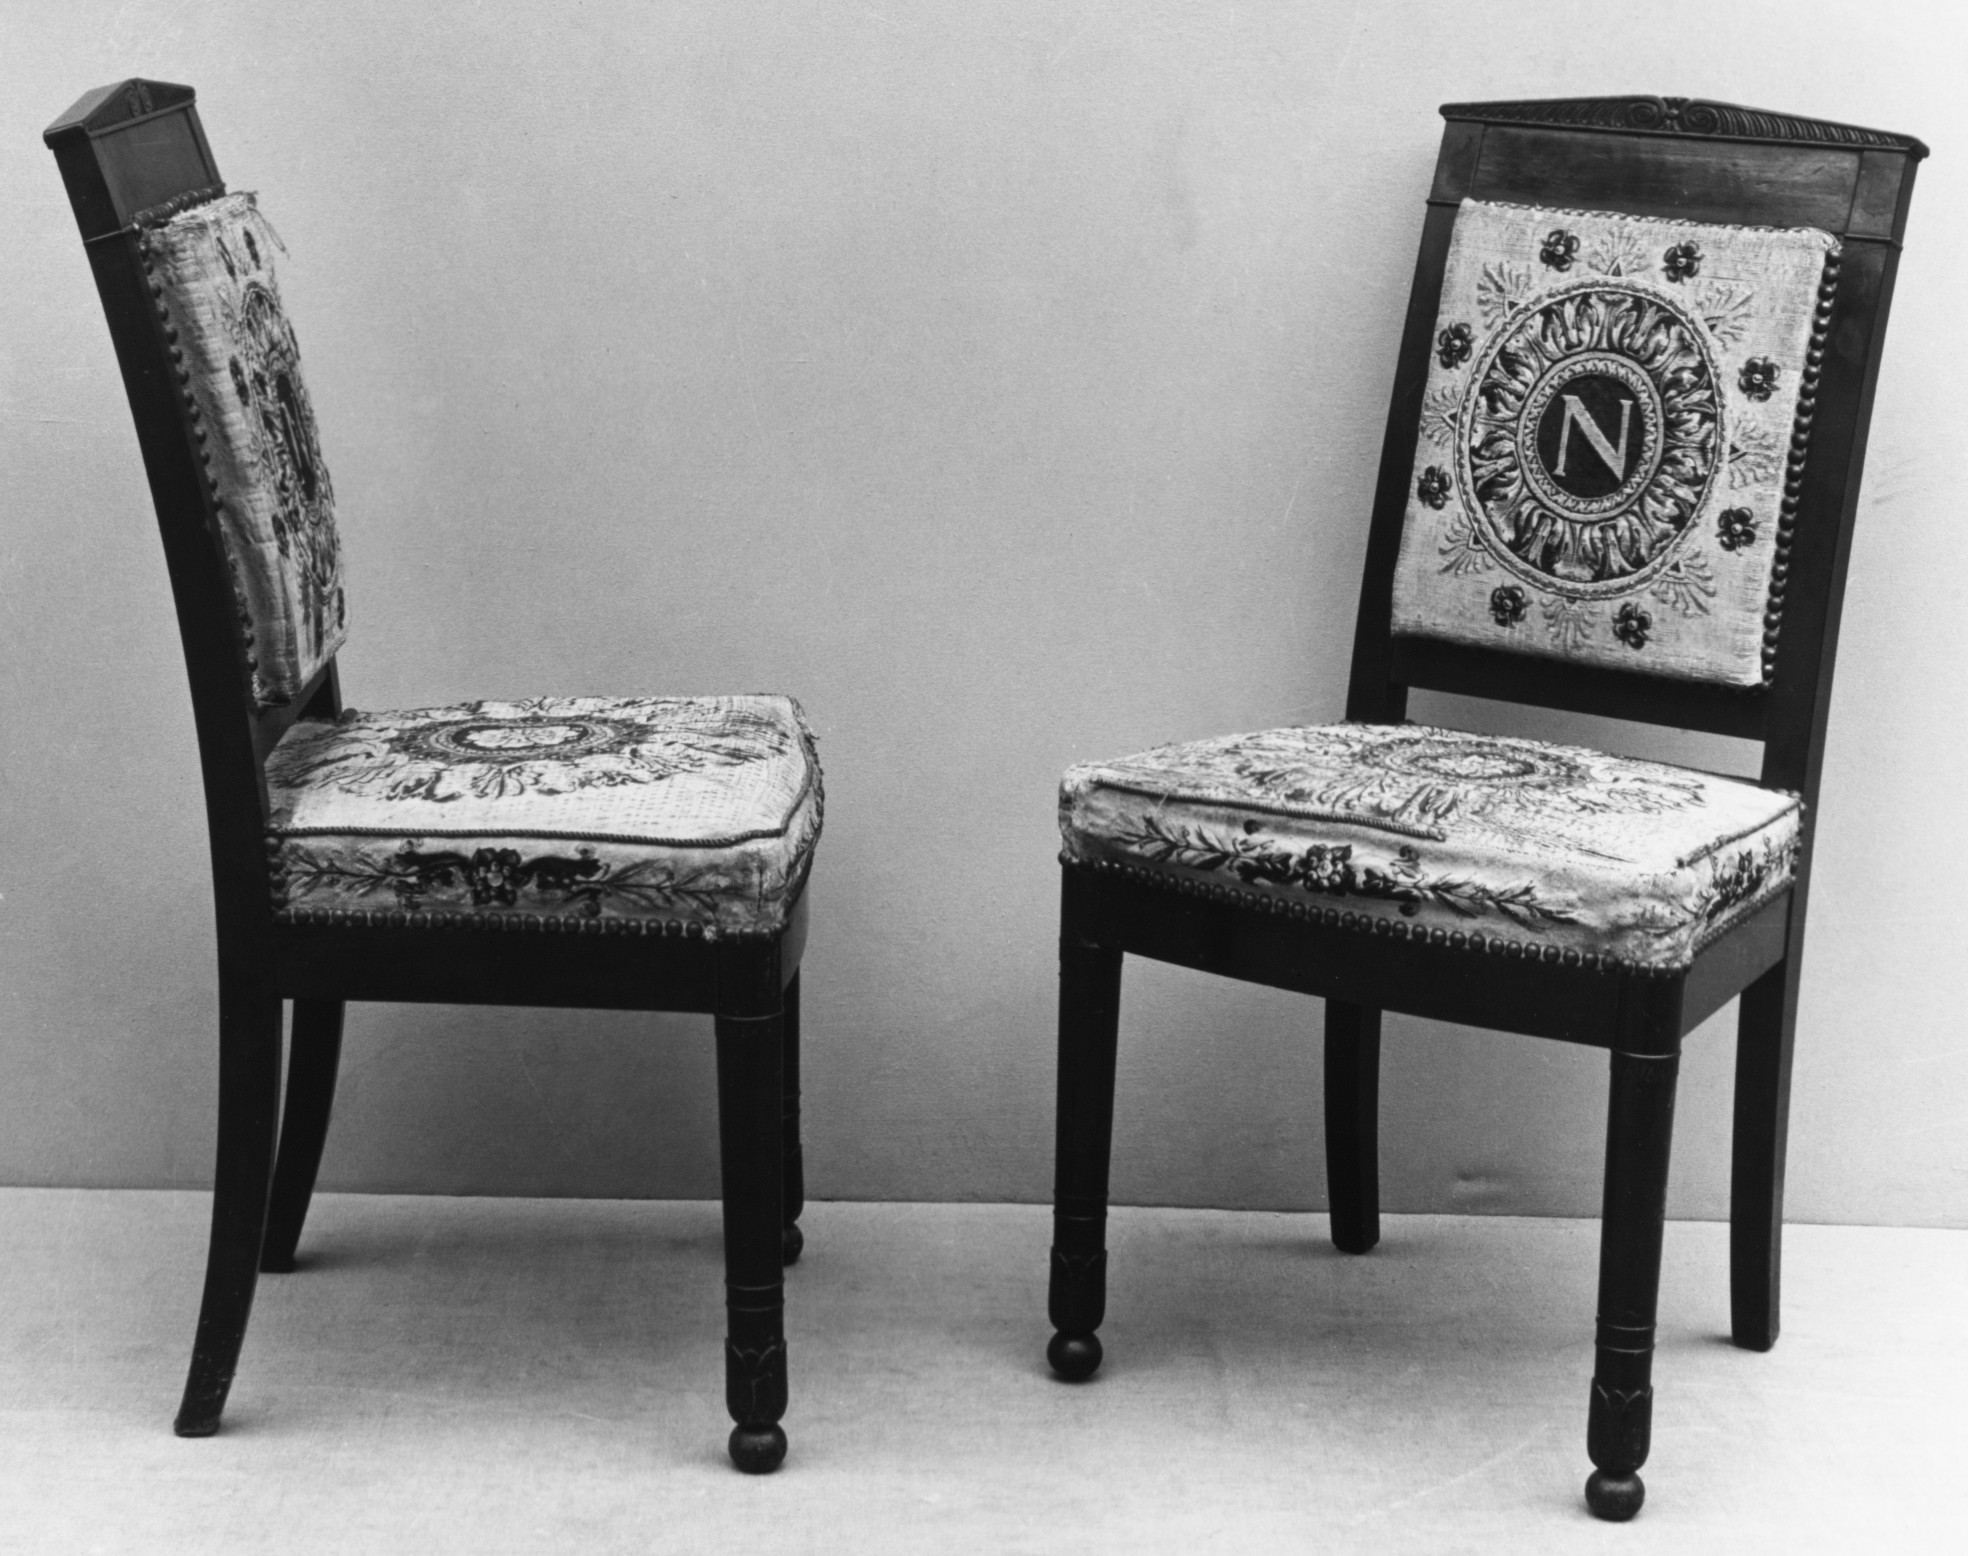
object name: chair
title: Chair (one of a pair)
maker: beauvais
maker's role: factory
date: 1801-1833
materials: wood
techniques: tapestry